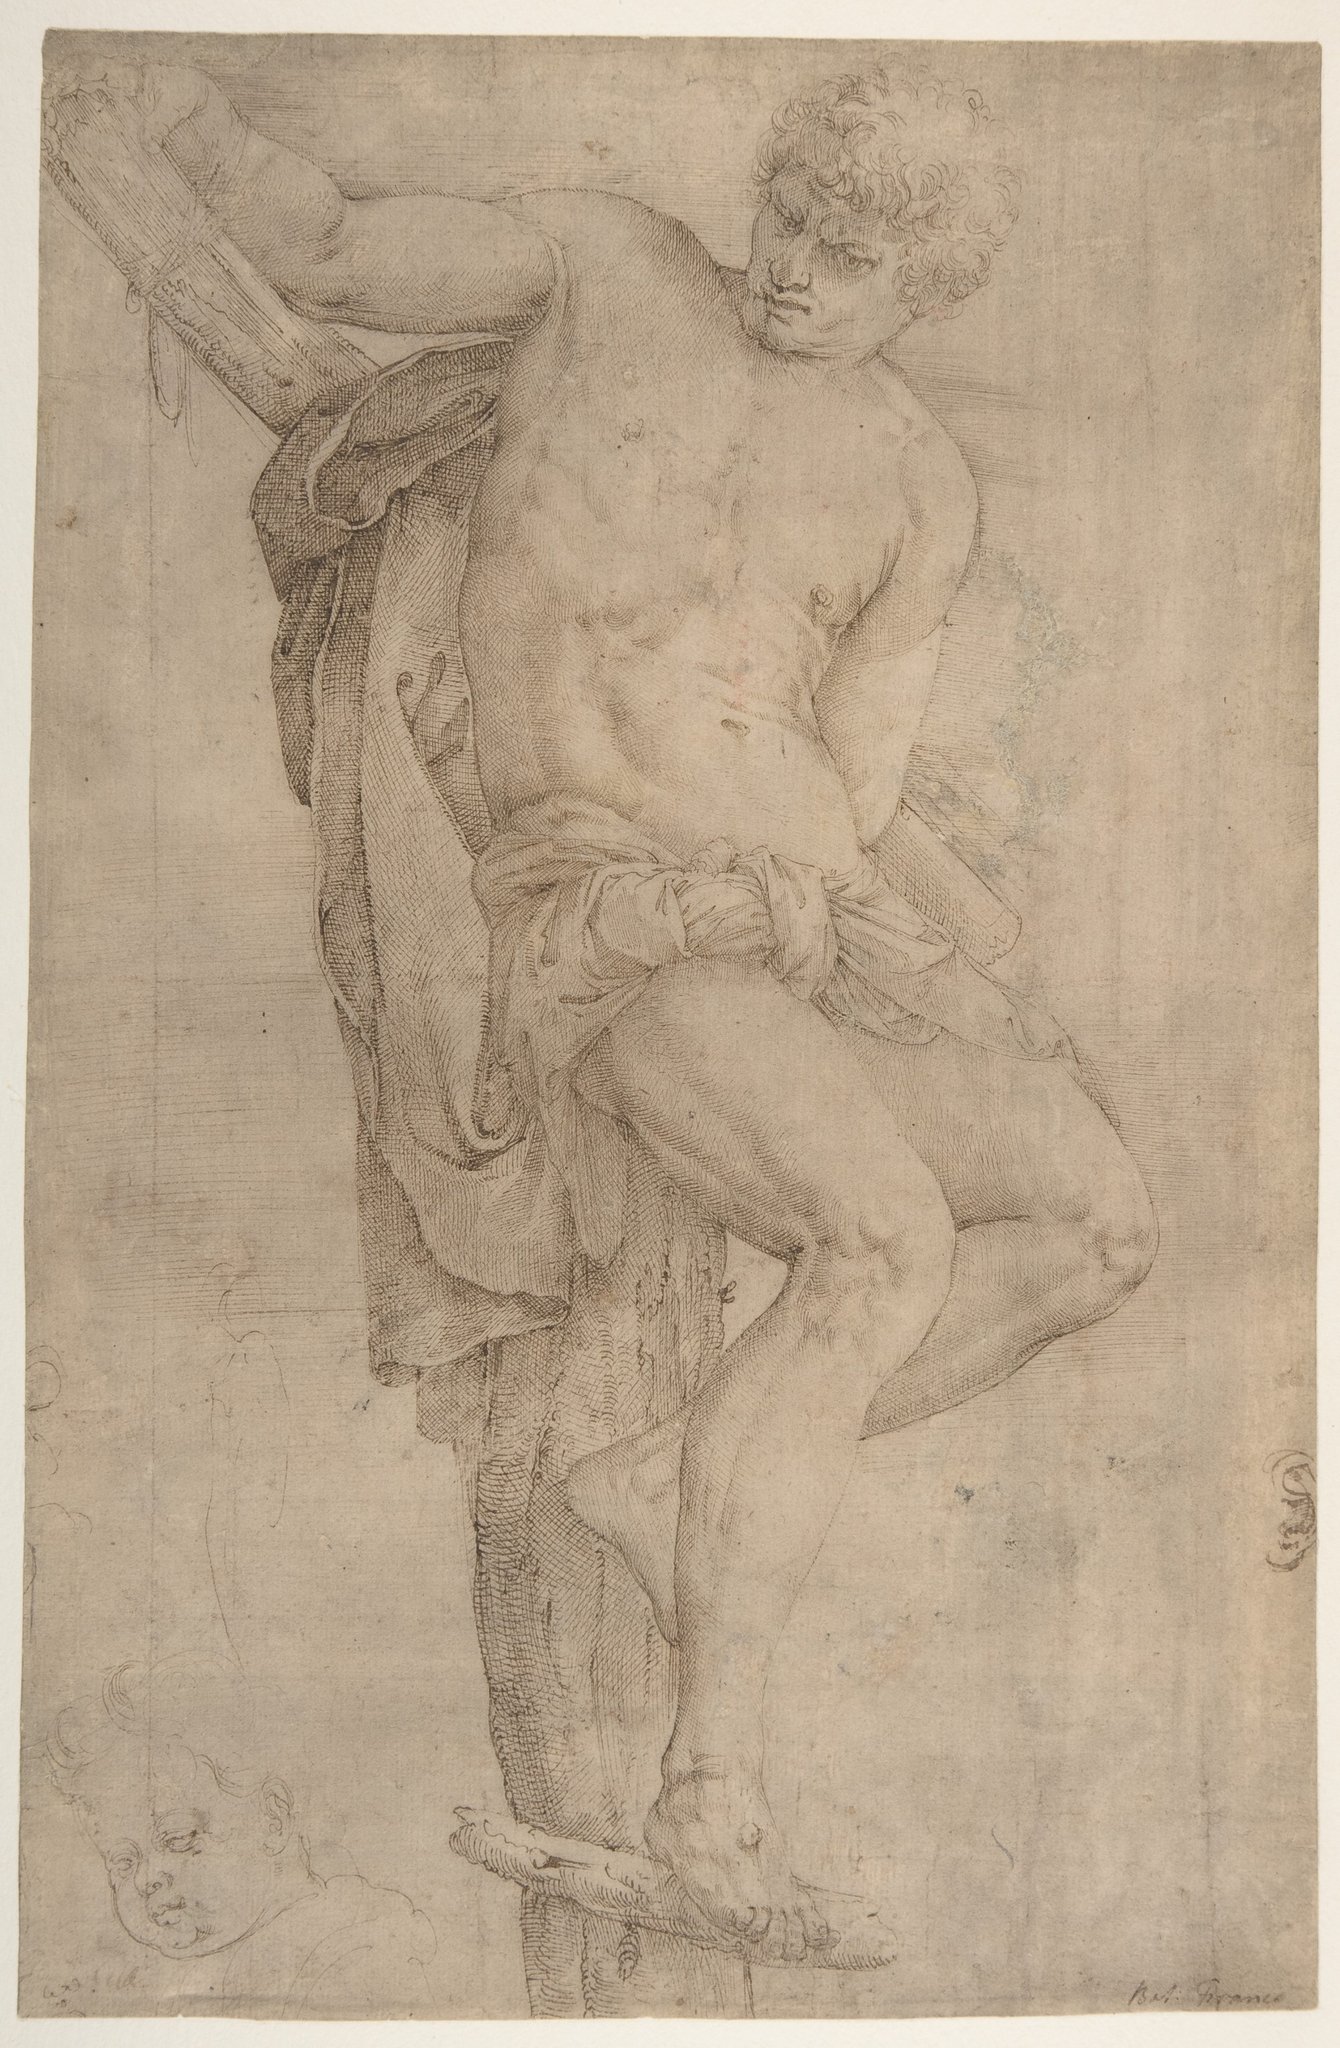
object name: drawing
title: The Unrepentant Thief on the Cross, Study of a Child's Head at Lower Left, and of an Ear at Lower Right Border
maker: battista franco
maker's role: artist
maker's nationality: italian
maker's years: 1510-1561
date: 1510-1561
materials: ink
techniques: pen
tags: men,cross